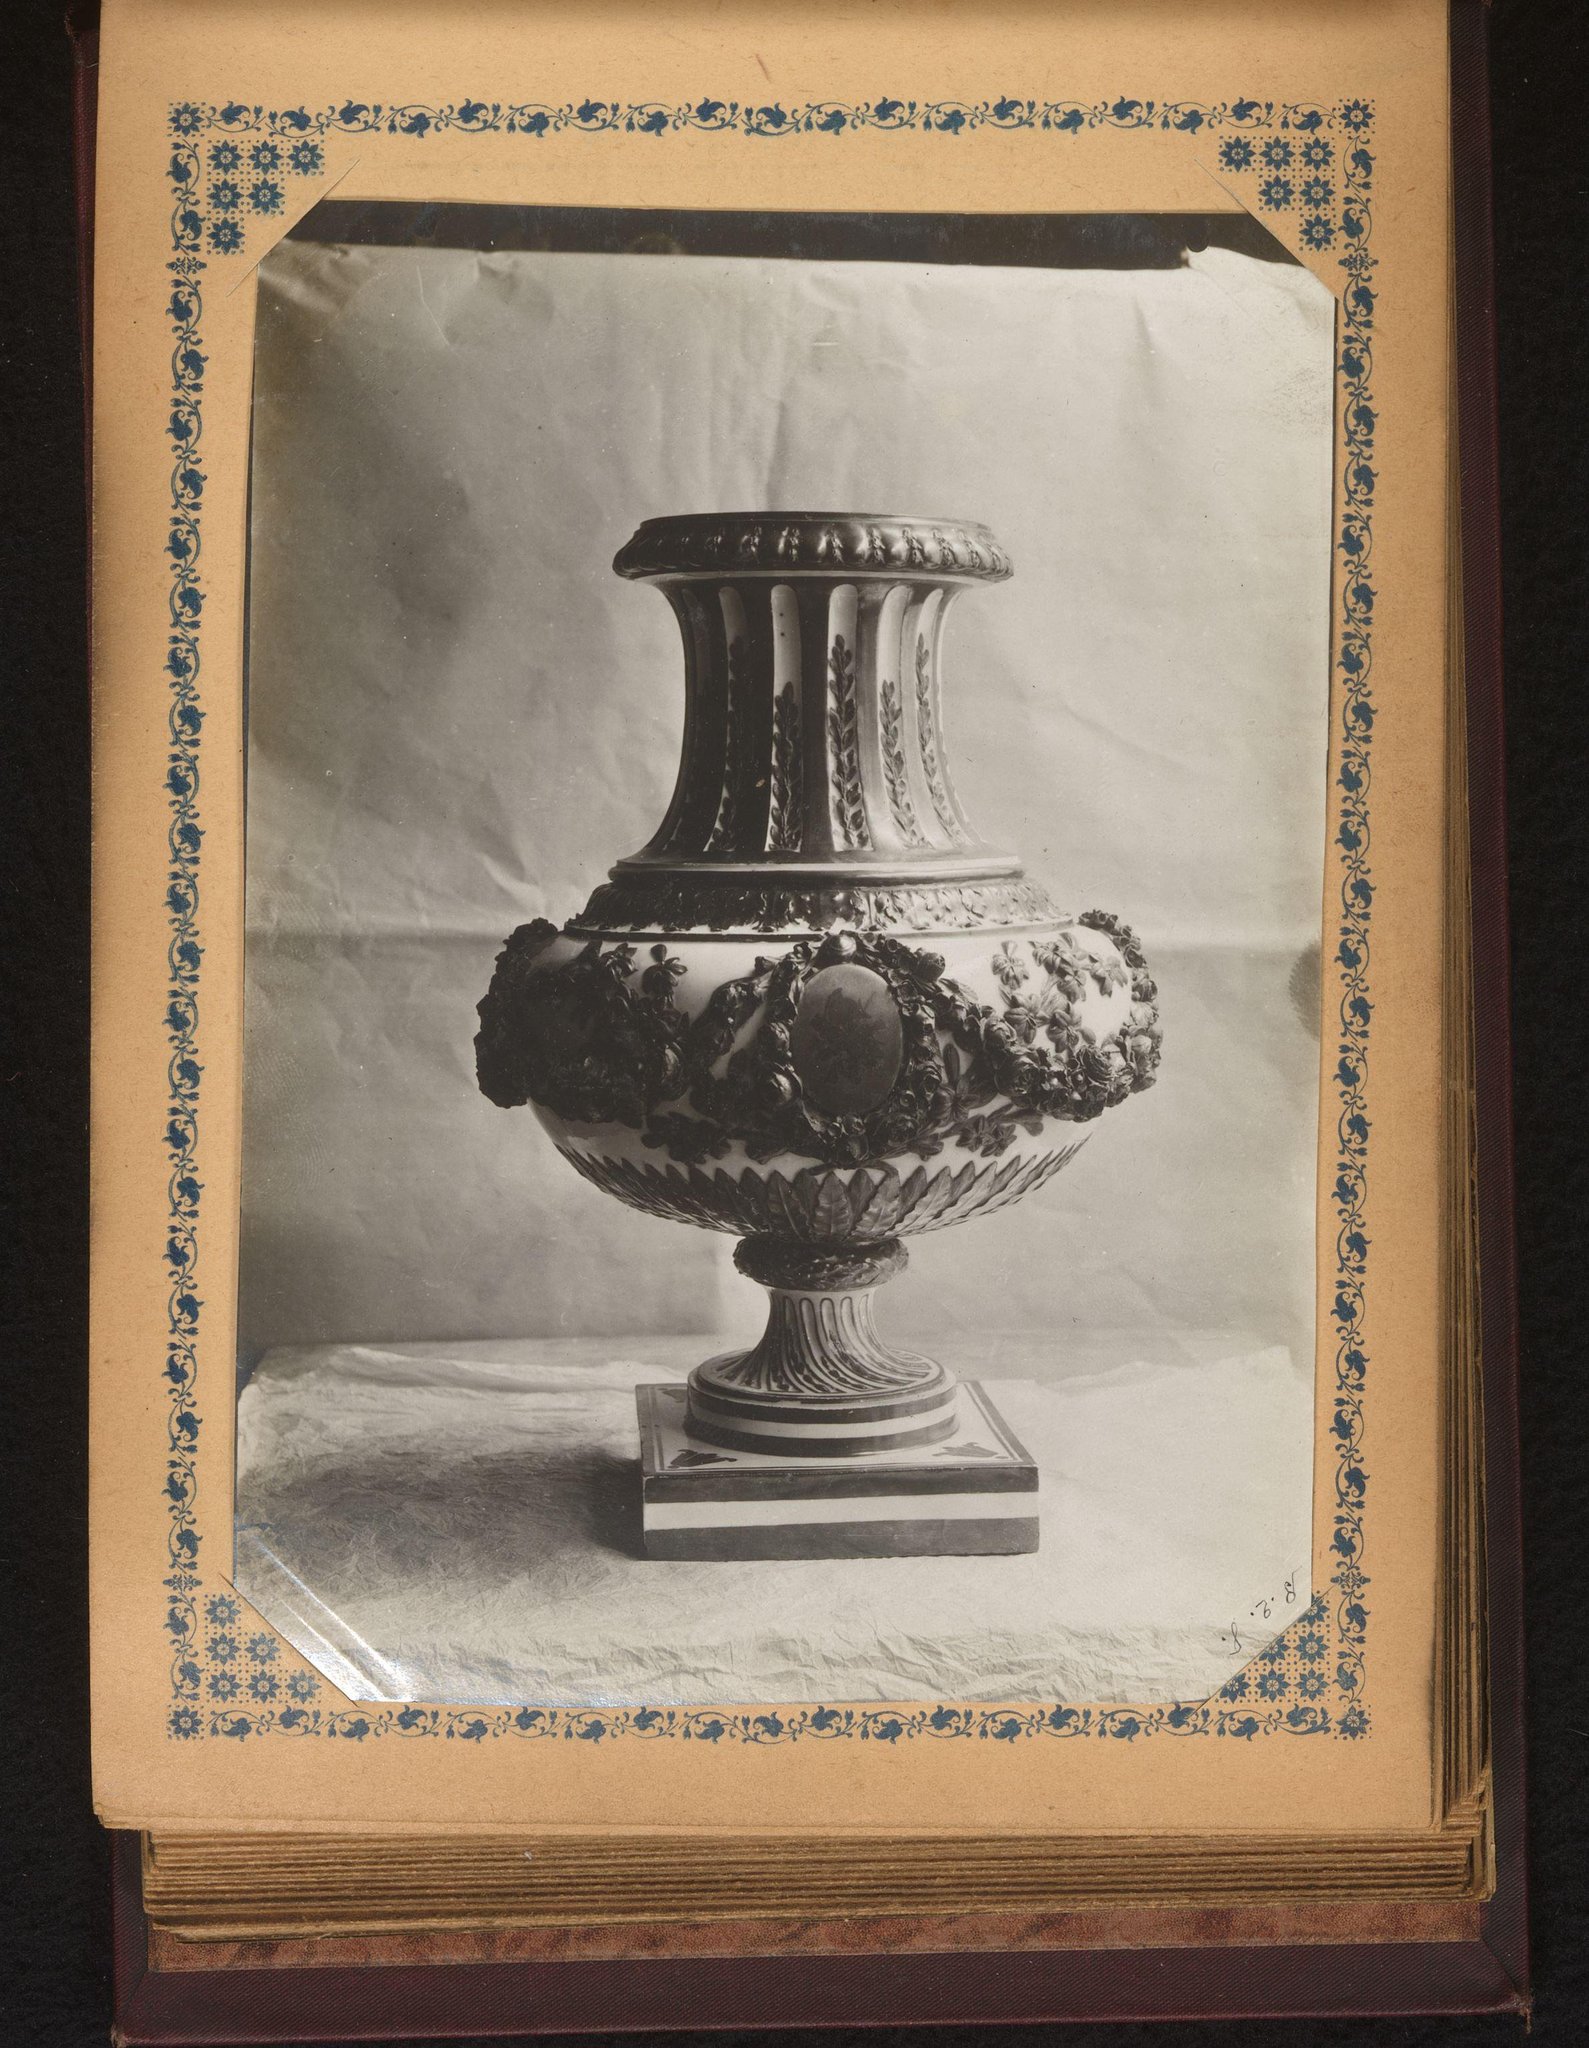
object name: photograph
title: Vaas gedecoreerd met een medaillon, bloemen, bladeren en takken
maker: Anonymous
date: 1880-1940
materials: cardboard, photographic support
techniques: gelatin silver print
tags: flowers, container of ceramics: jar, jug, pot, vase, foliage, tendrils, branches ~ ornament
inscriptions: number: ‘B. 2. 8.’